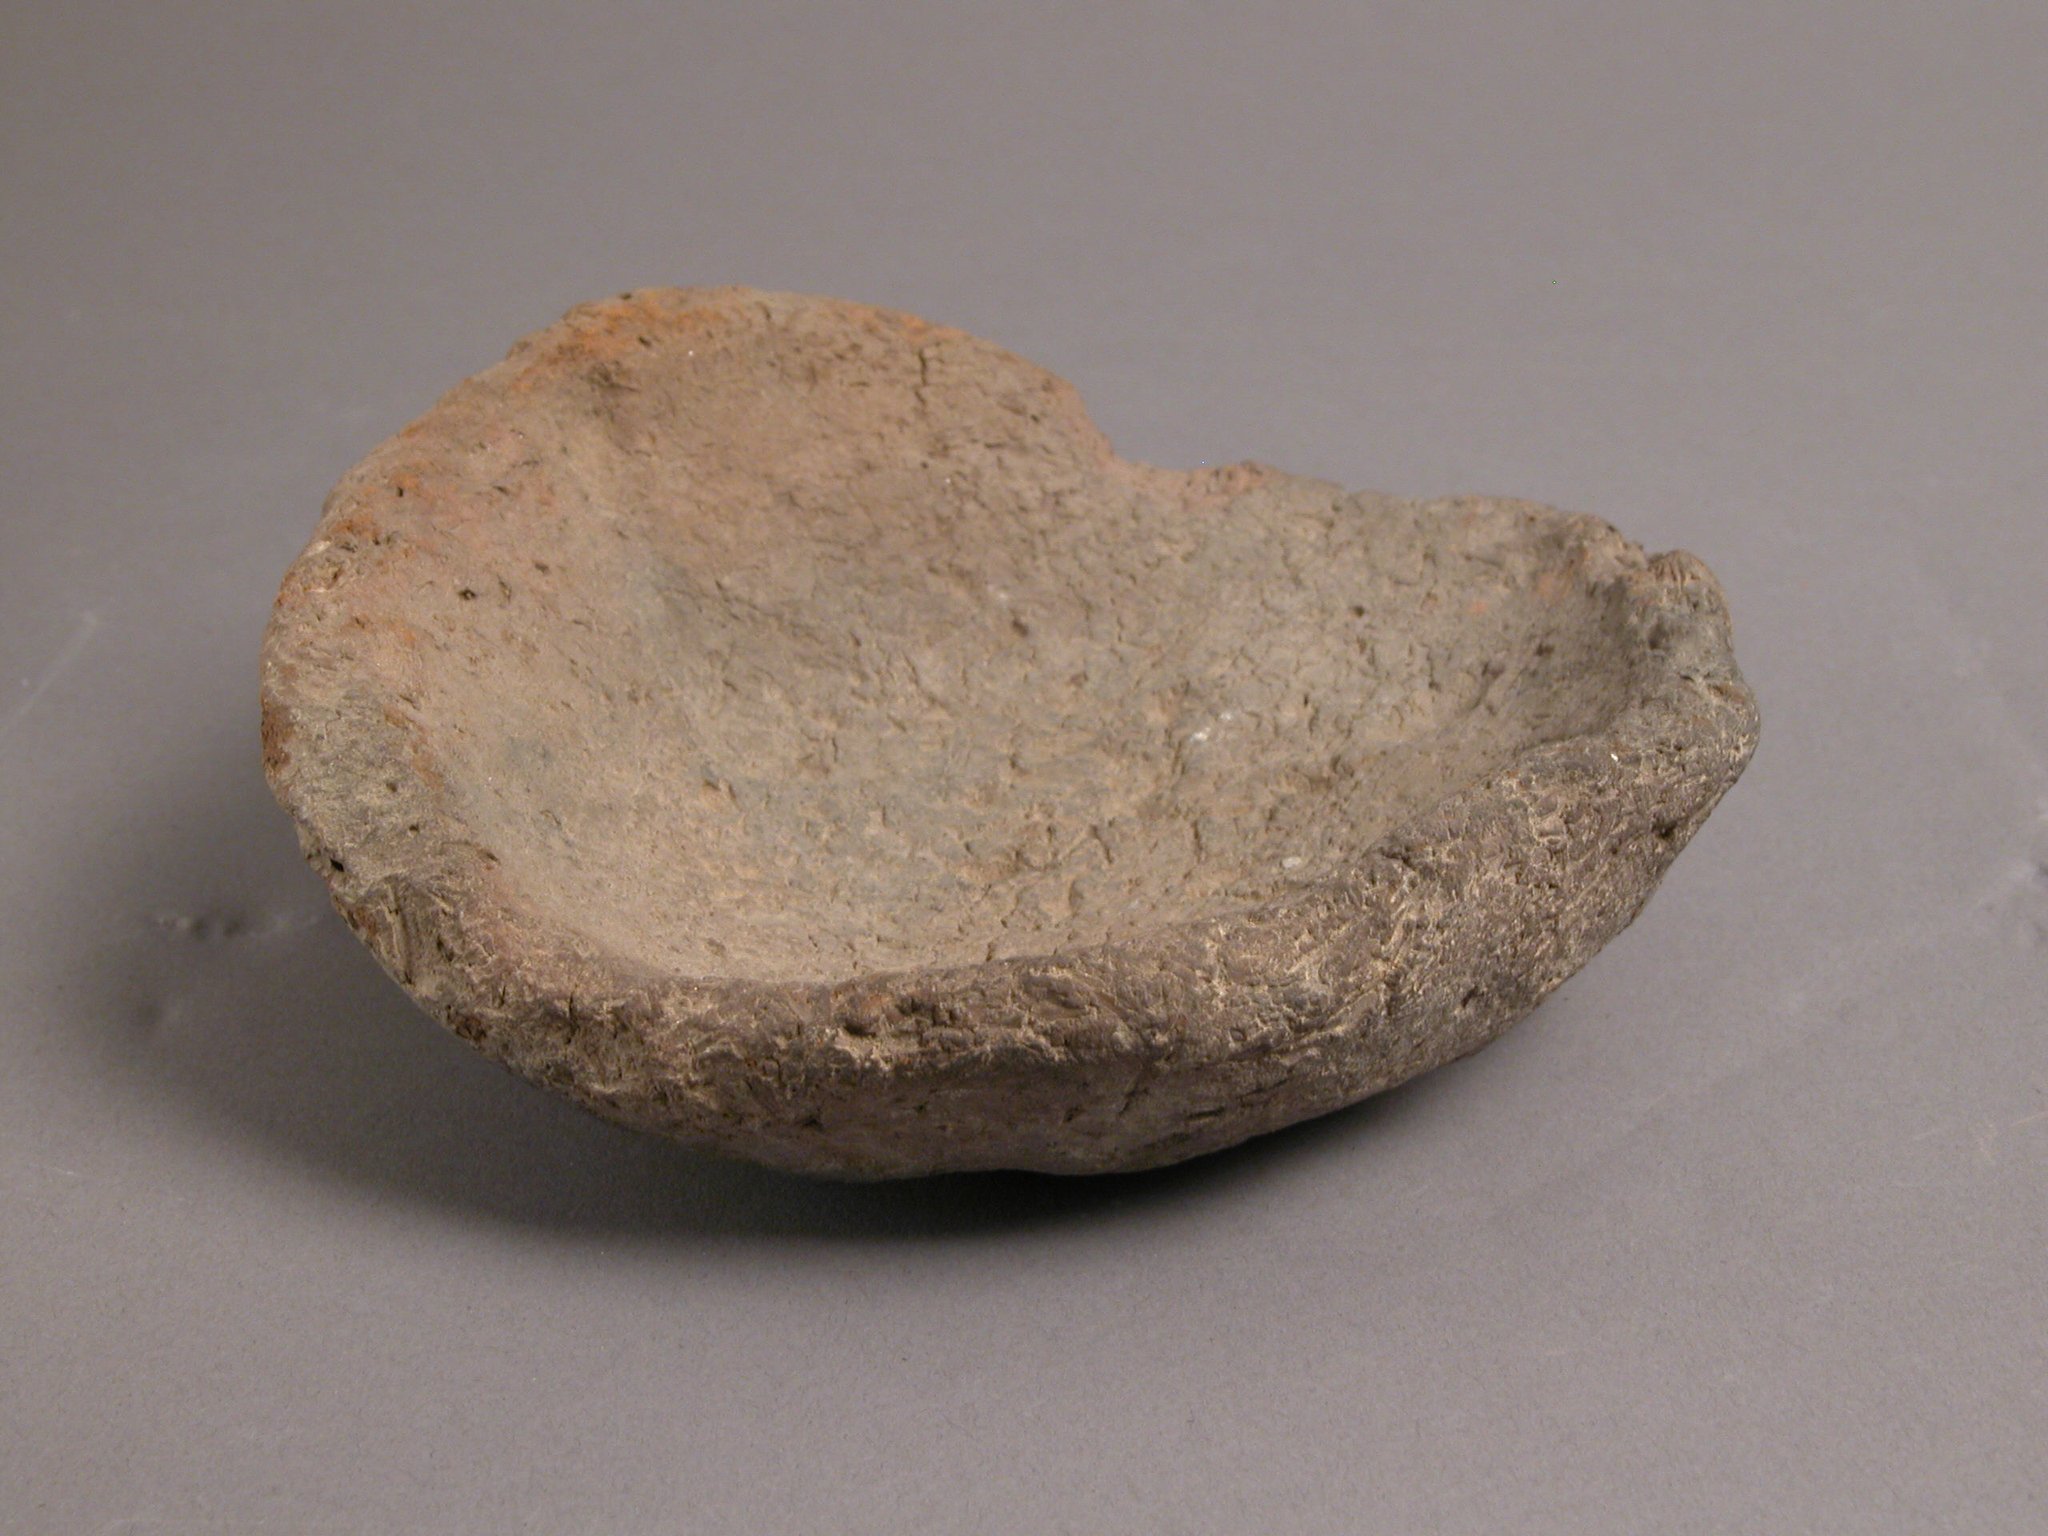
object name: bowl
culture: coptic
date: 301-700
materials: earthenware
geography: egypt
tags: bowls